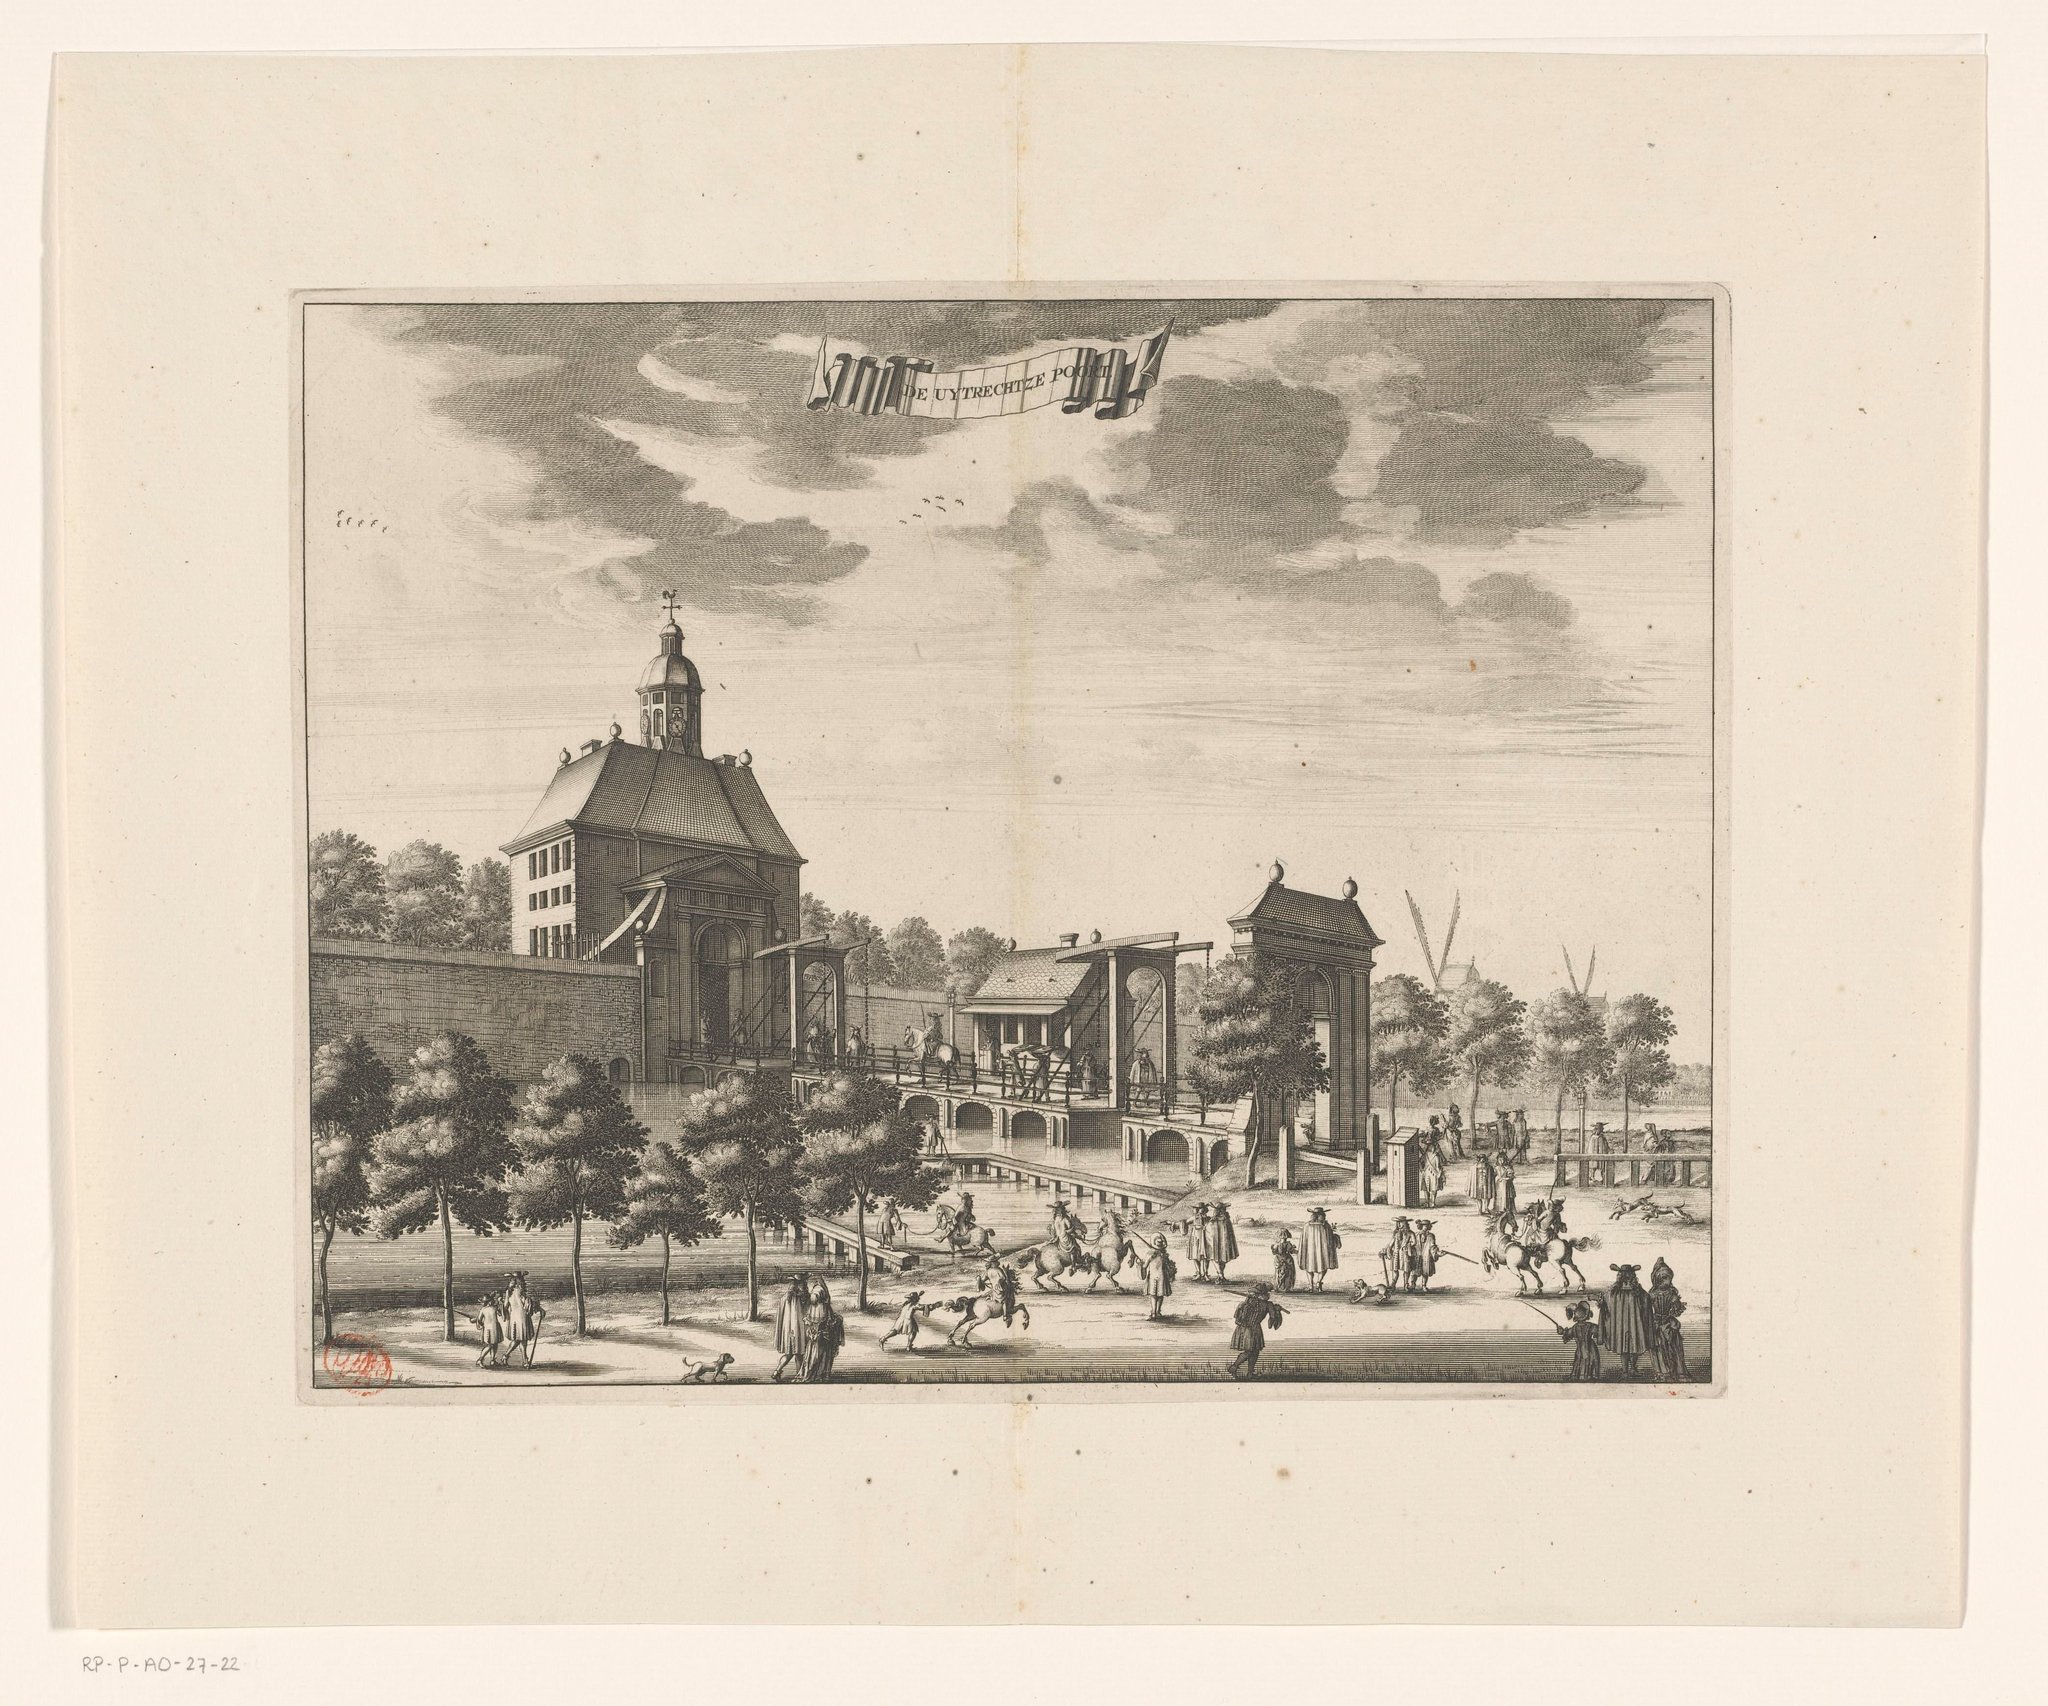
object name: book illustration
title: De Uytrechtze Poort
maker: Anonymous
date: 1693-1694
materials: paper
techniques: engraving, etching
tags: bridge, city-gate, canal (+ landscape with figures, staffage)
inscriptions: collector's mark: Lugt 195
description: Huidige staat van prent ook gebruikt in: Commelin, Caspar. Beschryvinge van Amsterdam, desselfs eerste oorspronk uyt den Huyse (…). 2 delen. Amsterdam: Abraham Wolfgang, Gillis Janssonius van Waesberge, Johannes Janssonius van Waesberge II, weduwe Dirk Boom I, Hendrick Boom en Rembertus Goethals, 1693. En in: Commelin, Caspar. Beschryvinge van Amsterdam, zynde een naukeurige verhandelinge van desselfs eerste oorspronk uyt (…). 2 delen. Amsterdam: weduwe Aart Dircksz Oossaan, 1694. Latere staat ook gebruikt in: Commelin, Caspar. Beschryvinge van Amsterdam, zynde een naukeurige verhandelinge van desselfs eerste oorspronk uyt (…). 2 delen. 2e druk. Amsterdam: Andries van Damme, Johannes Ratelband, weduwe A. van Aaltwyk en Hermanus Uytwerf, 1726.